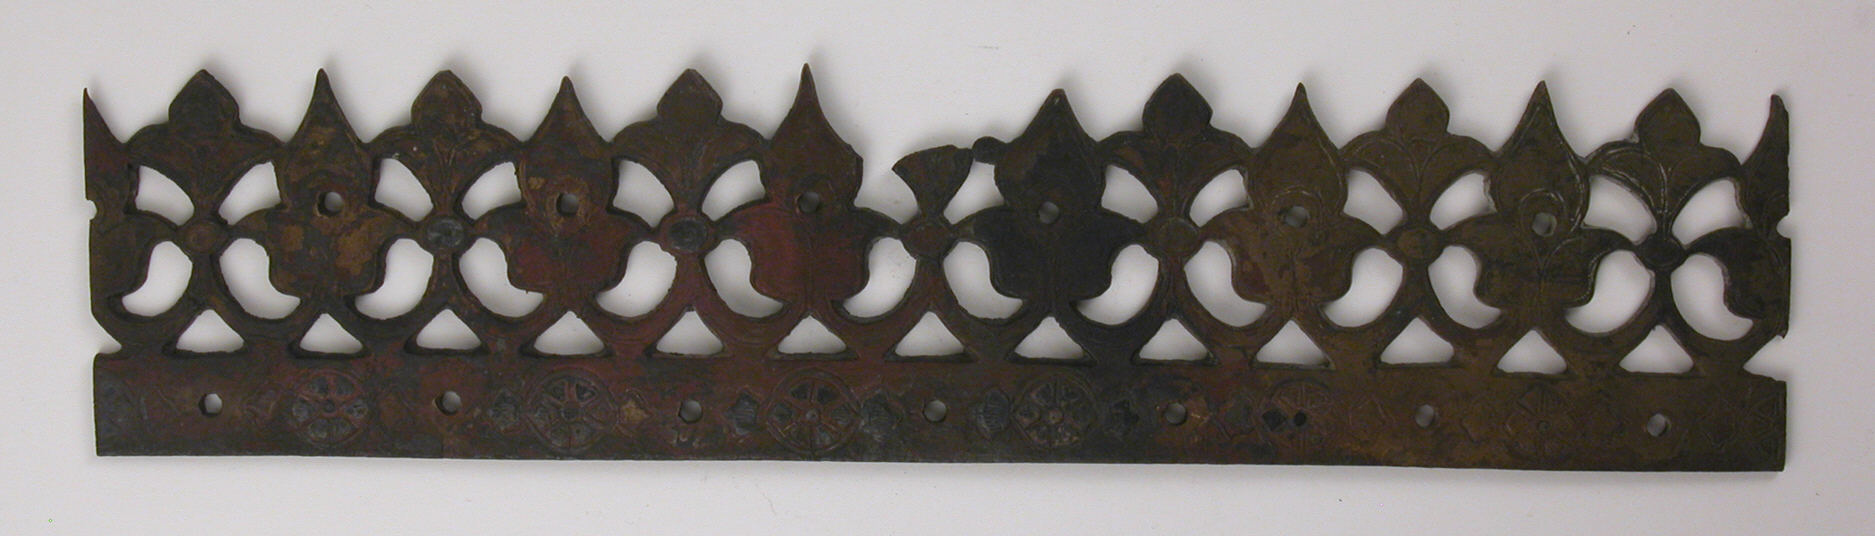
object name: ornament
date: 1201-1300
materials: brass, silver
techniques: inlay, painting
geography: egypt